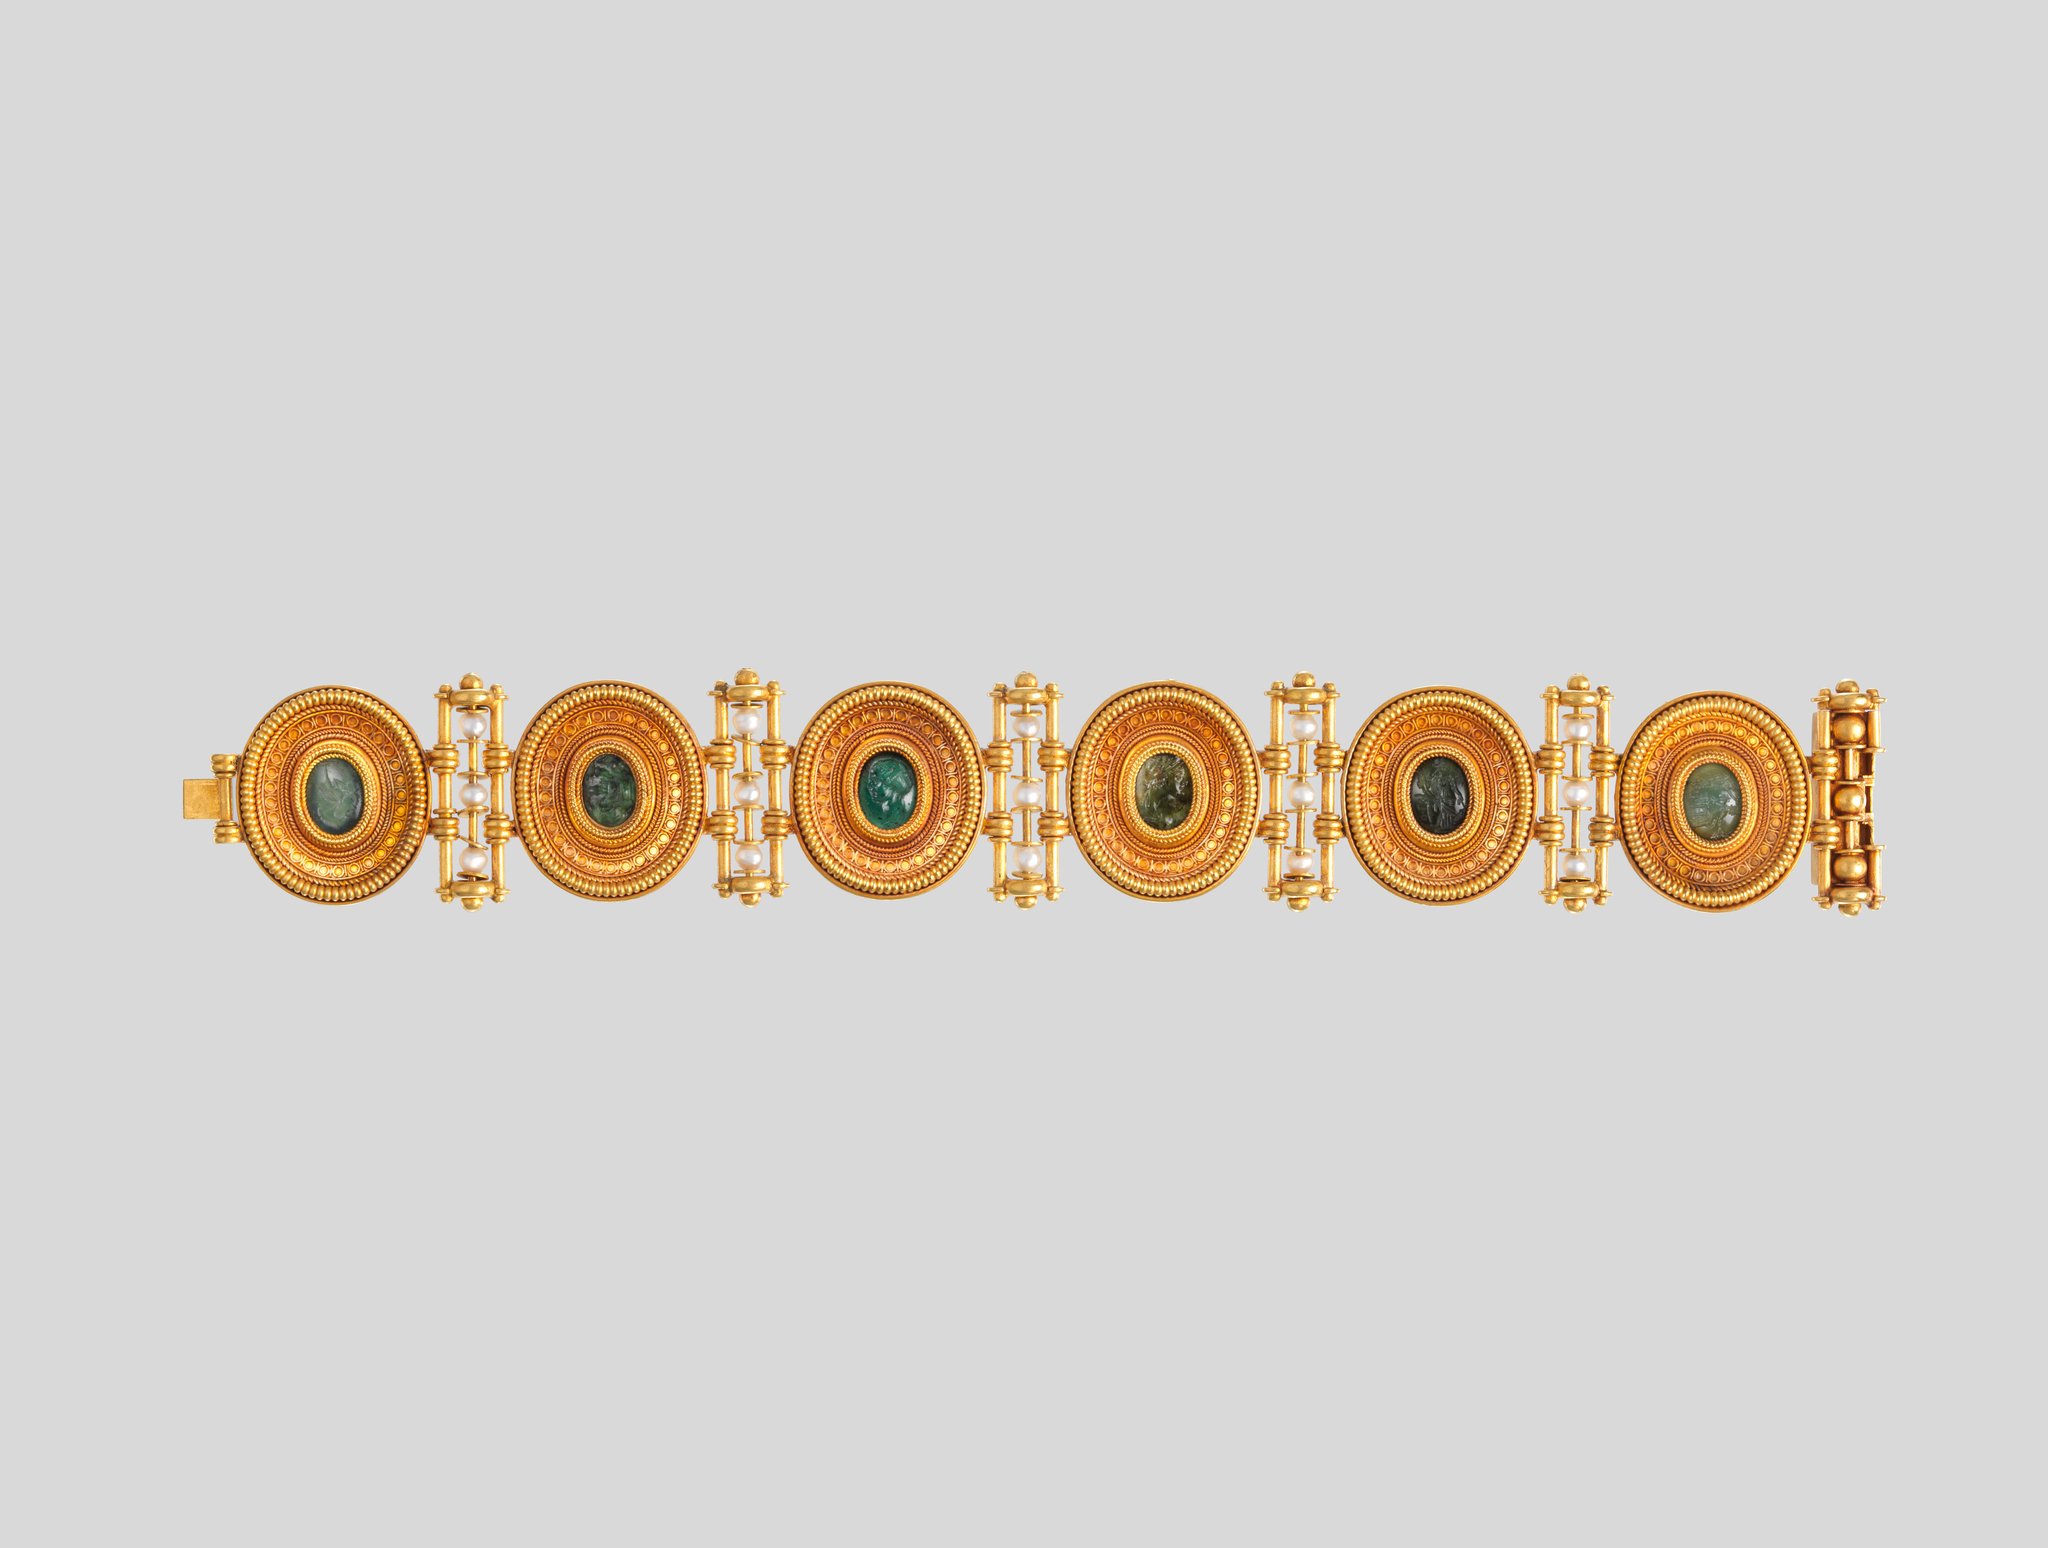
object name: bracelet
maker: castellani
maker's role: maker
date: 1860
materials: gold